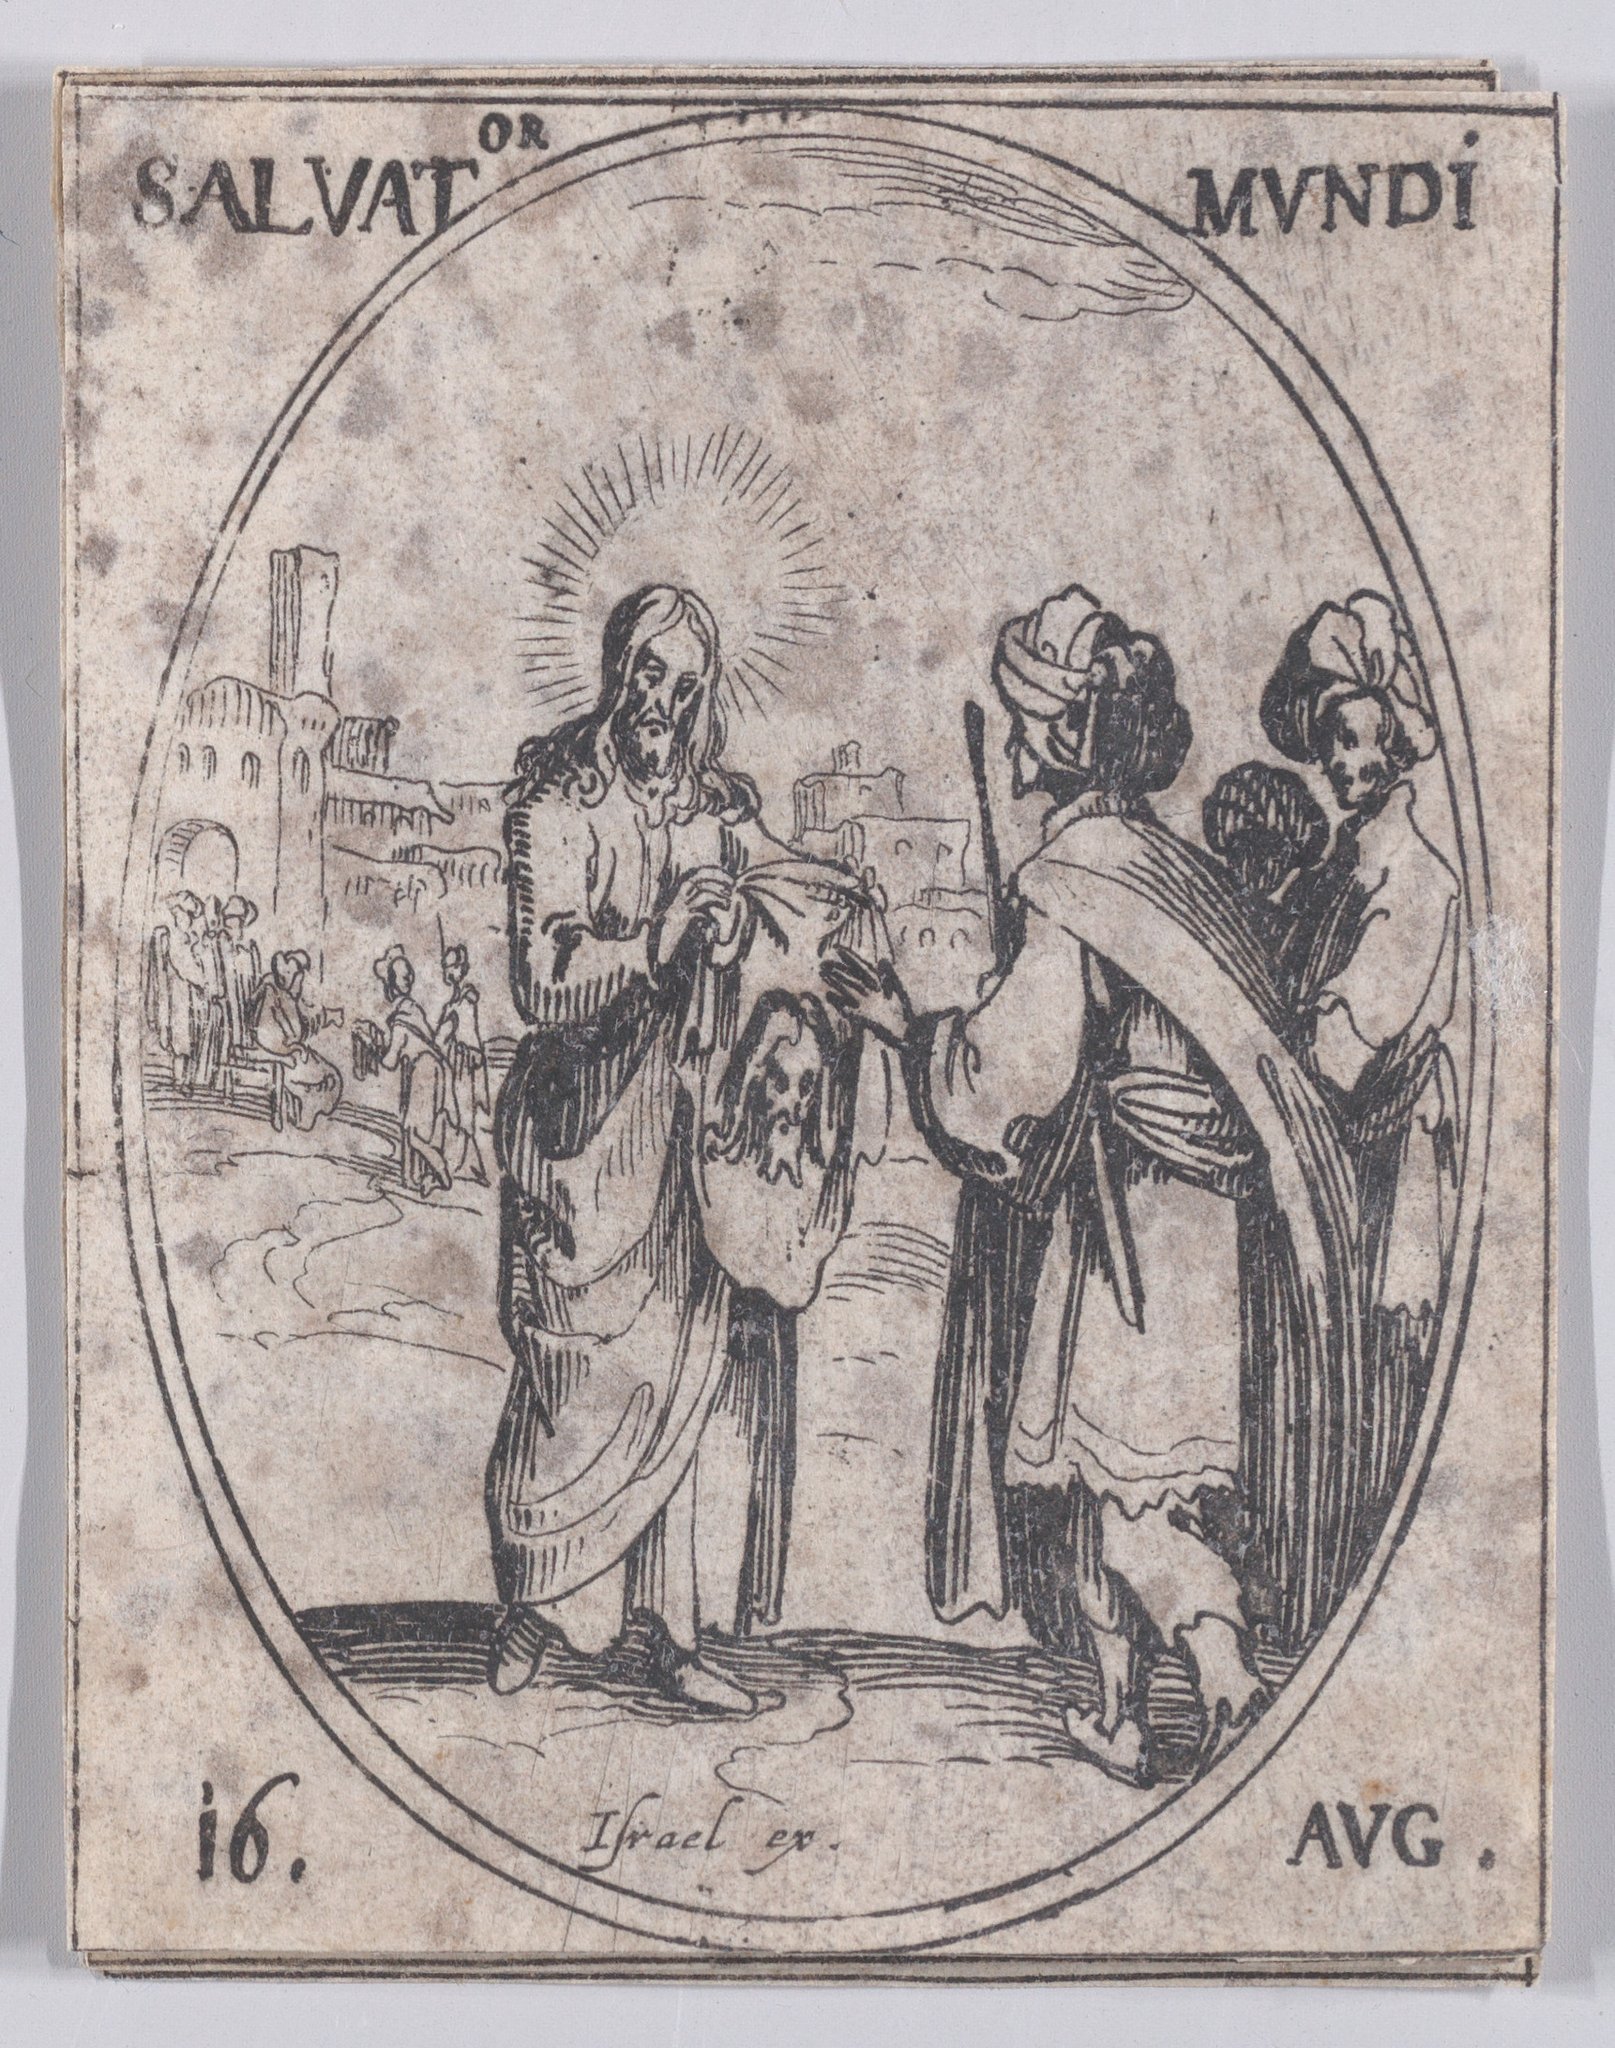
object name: print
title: La Sauveur du Monde (Salvator Mundi), August 16th, from "Les Images De Tous Les Saincts et Saintes de L'Année" (Images of All of the Saints and Religious Events of the Year)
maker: jacques callot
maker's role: artist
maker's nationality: french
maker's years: 1592-1635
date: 1636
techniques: etching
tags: men,christ